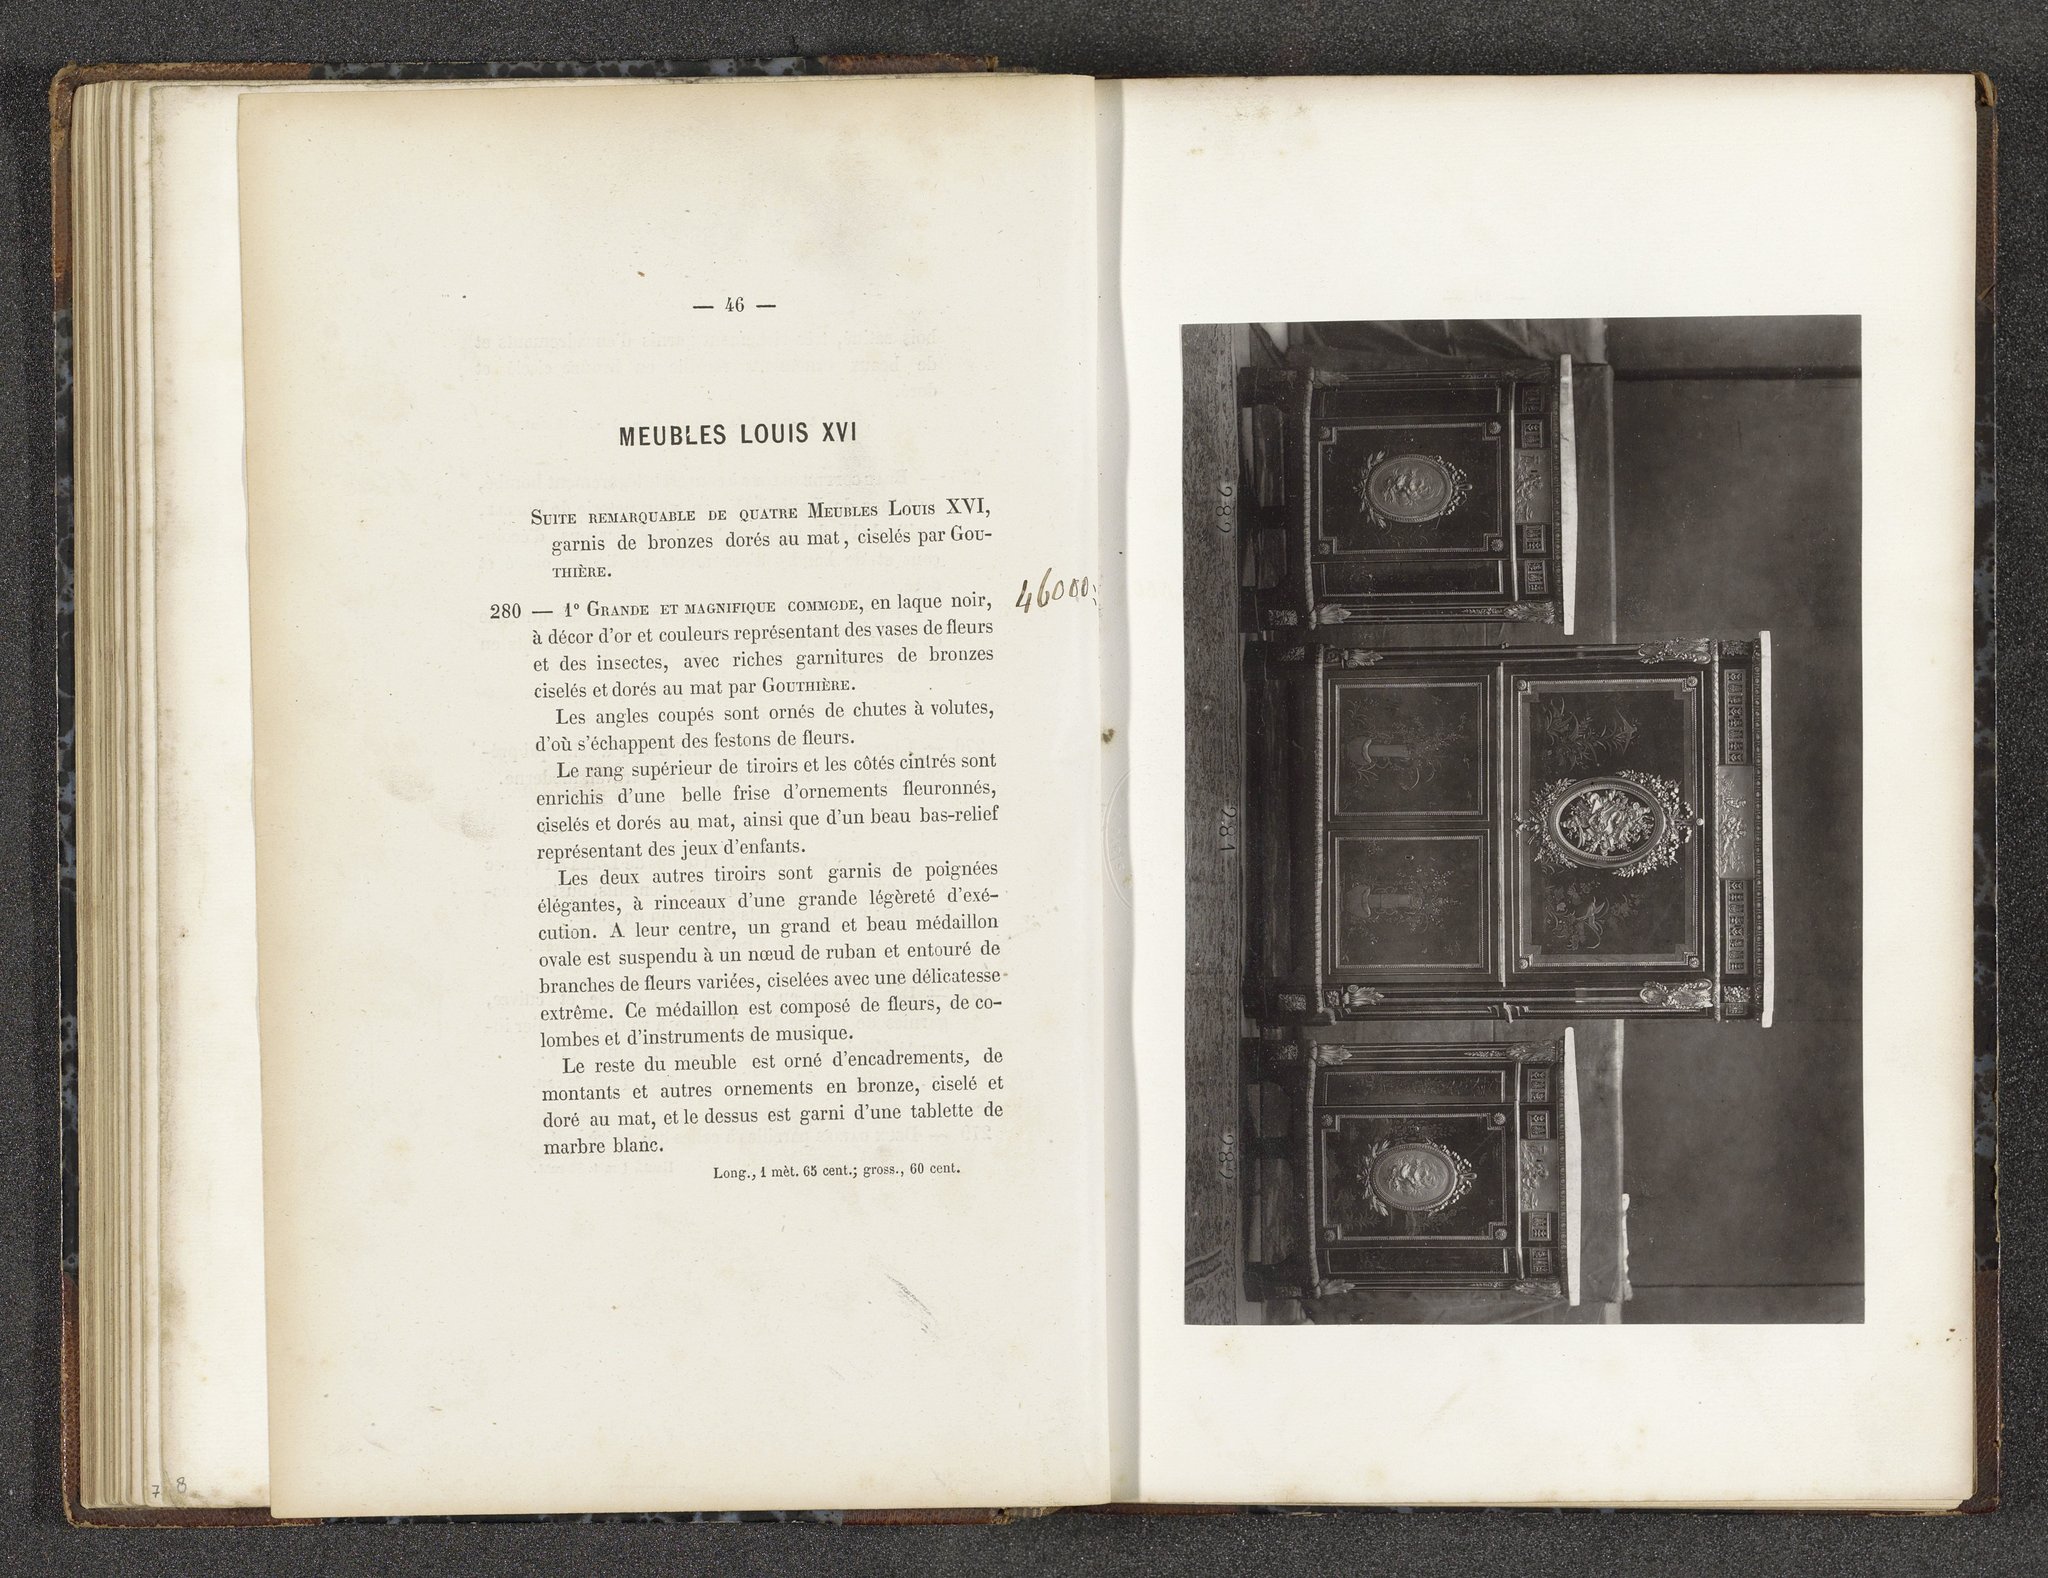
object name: photomechanical print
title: Secretaire en twee driehoekige hoekmeubelen gedecoreerd met medaillons en plantmotieven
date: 1870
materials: paper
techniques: woodburytype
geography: paris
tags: ornamental cupboard, writing-table, writing-desk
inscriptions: number: ‘281 282’, name: ‘De Goupil & Cie Imp. Photoglytique Paris’